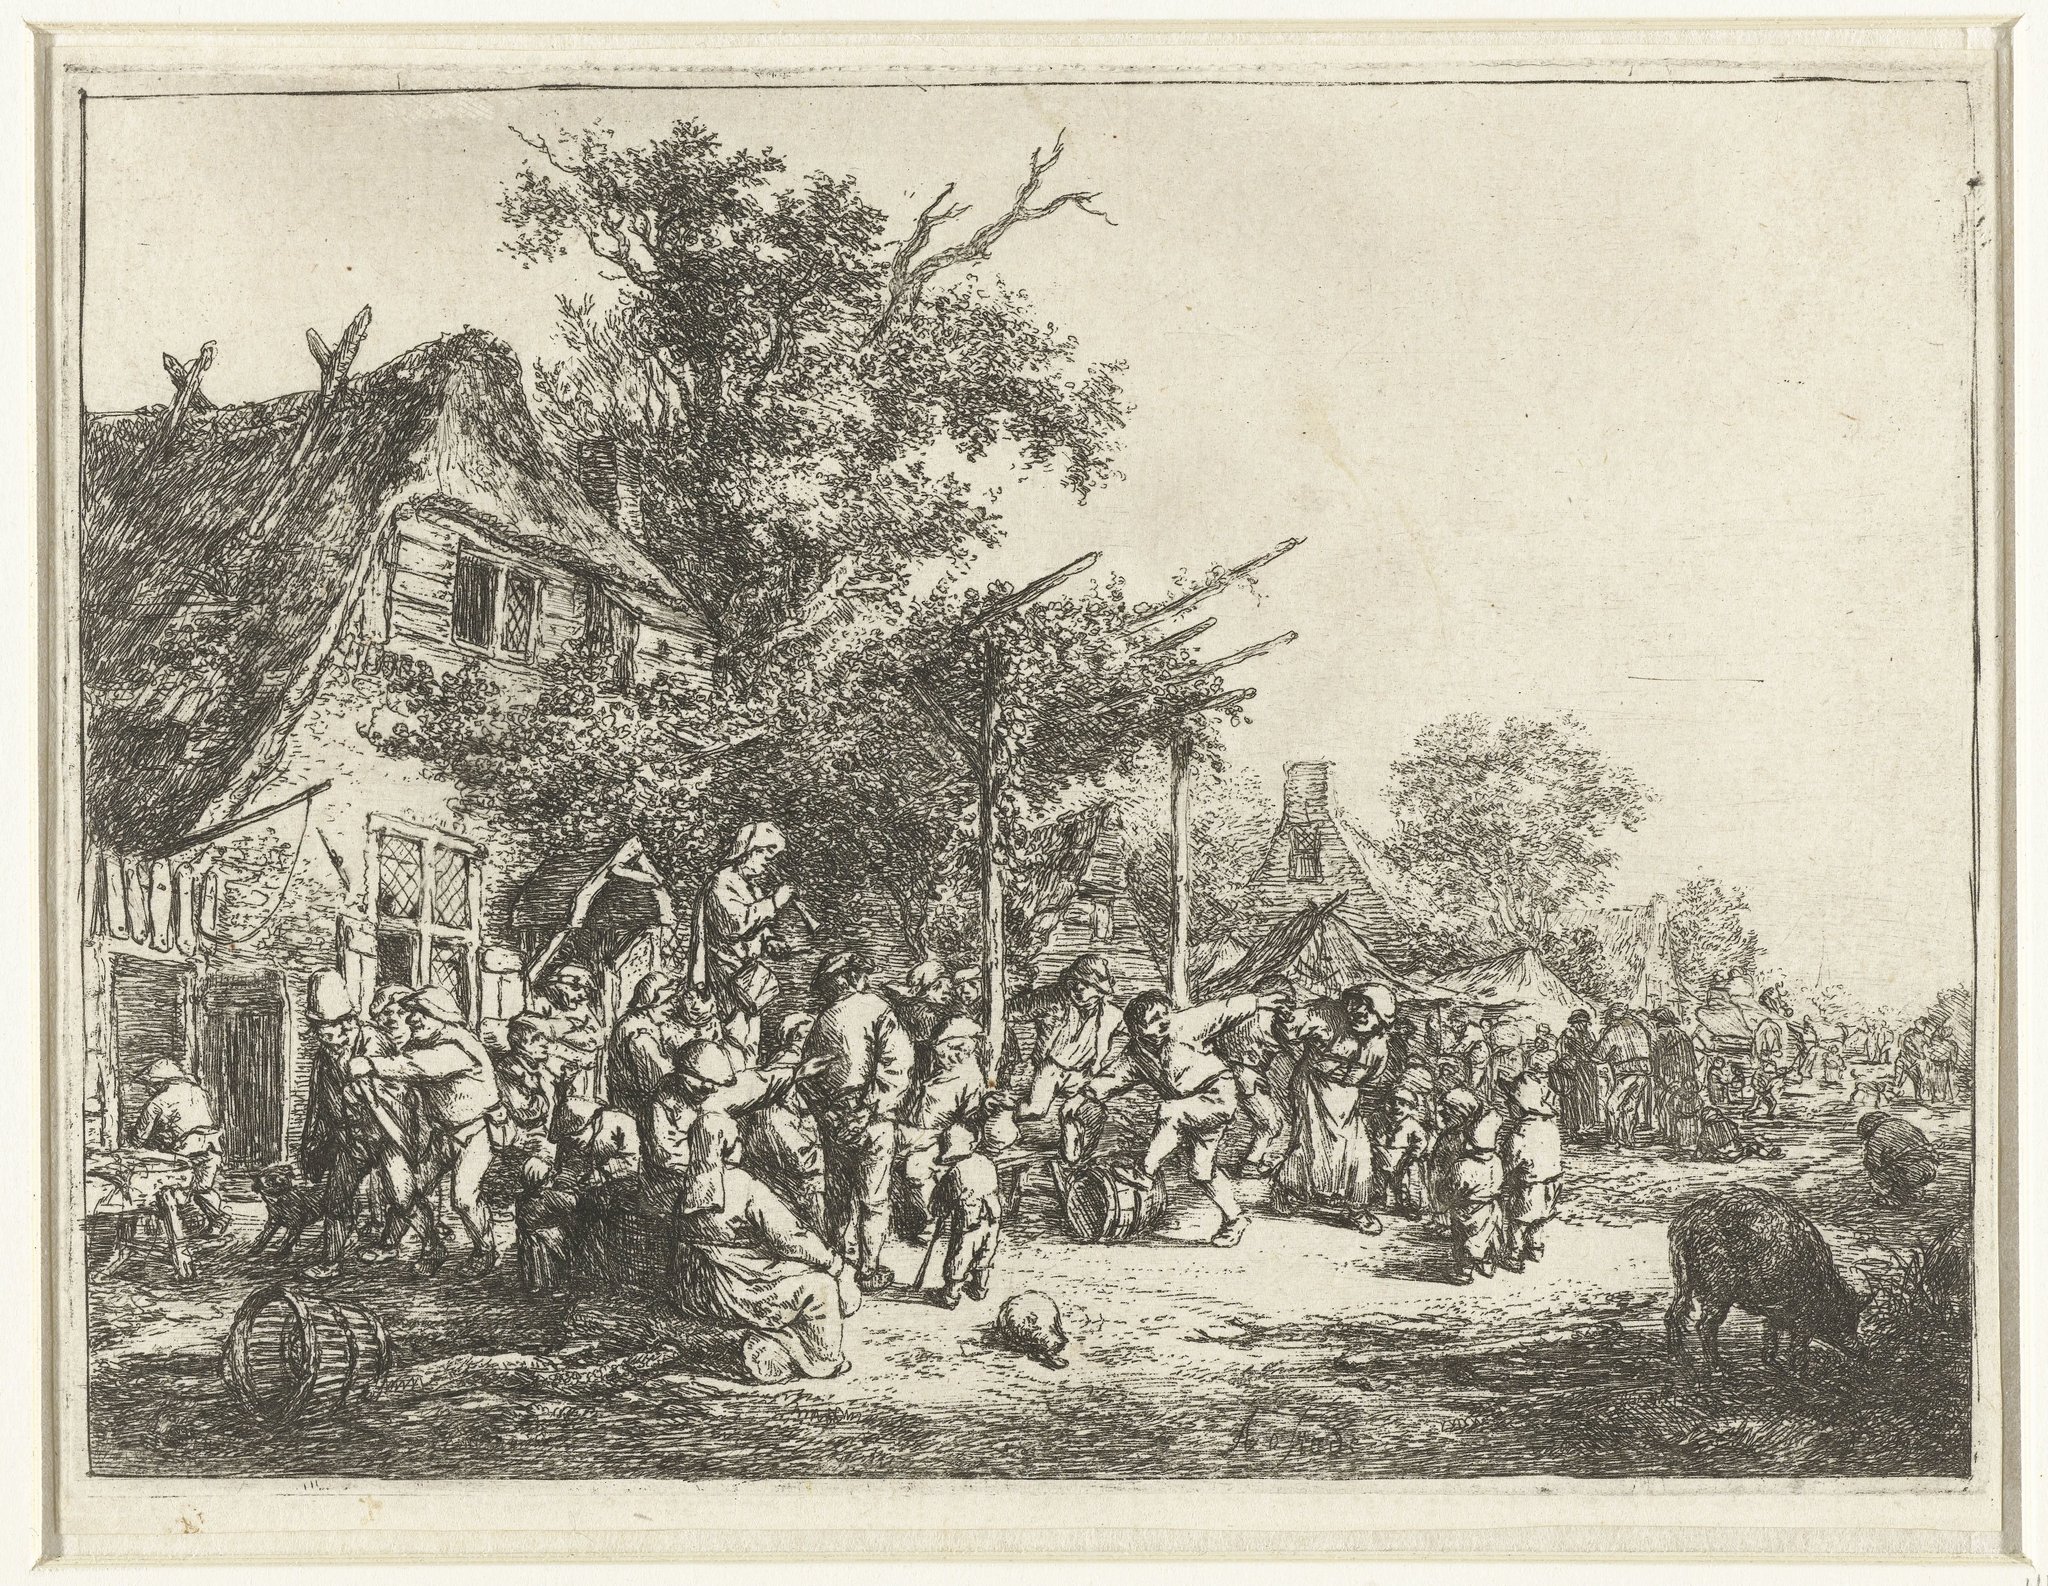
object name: print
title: Dansende boeren voor een herberg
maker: adriaen van ostade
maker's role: draughtsman, painter, print maker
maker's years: 1610-1685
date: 1651-1655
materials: paper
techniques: etching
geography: haarlem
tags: one pair dancing; man and woman dancing as a couple, public festivities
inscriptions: collector's mark: Lugt 240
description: In een dorpsstraat wordt feest gevierd waarbij het er vrolijk aan toegaat. Een groot aantal dorpsbewoners kijkt geanimeerd toe hoe een man en vrouw dansen op de muziek van een muzikant.